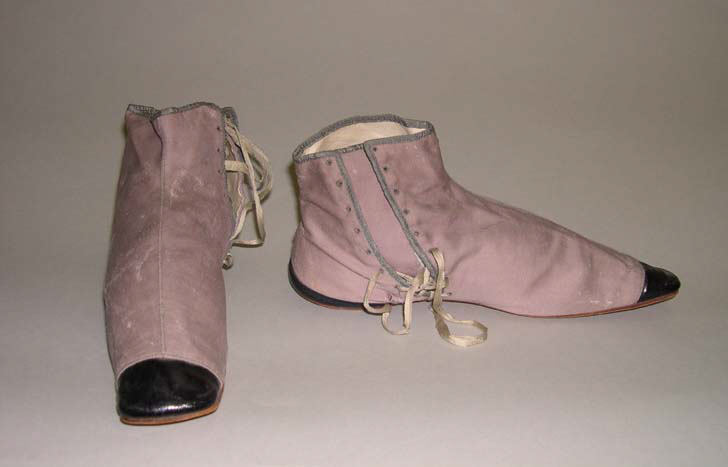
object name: boot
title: Boots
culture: american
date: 1830-1839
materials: cotton, leather, wool